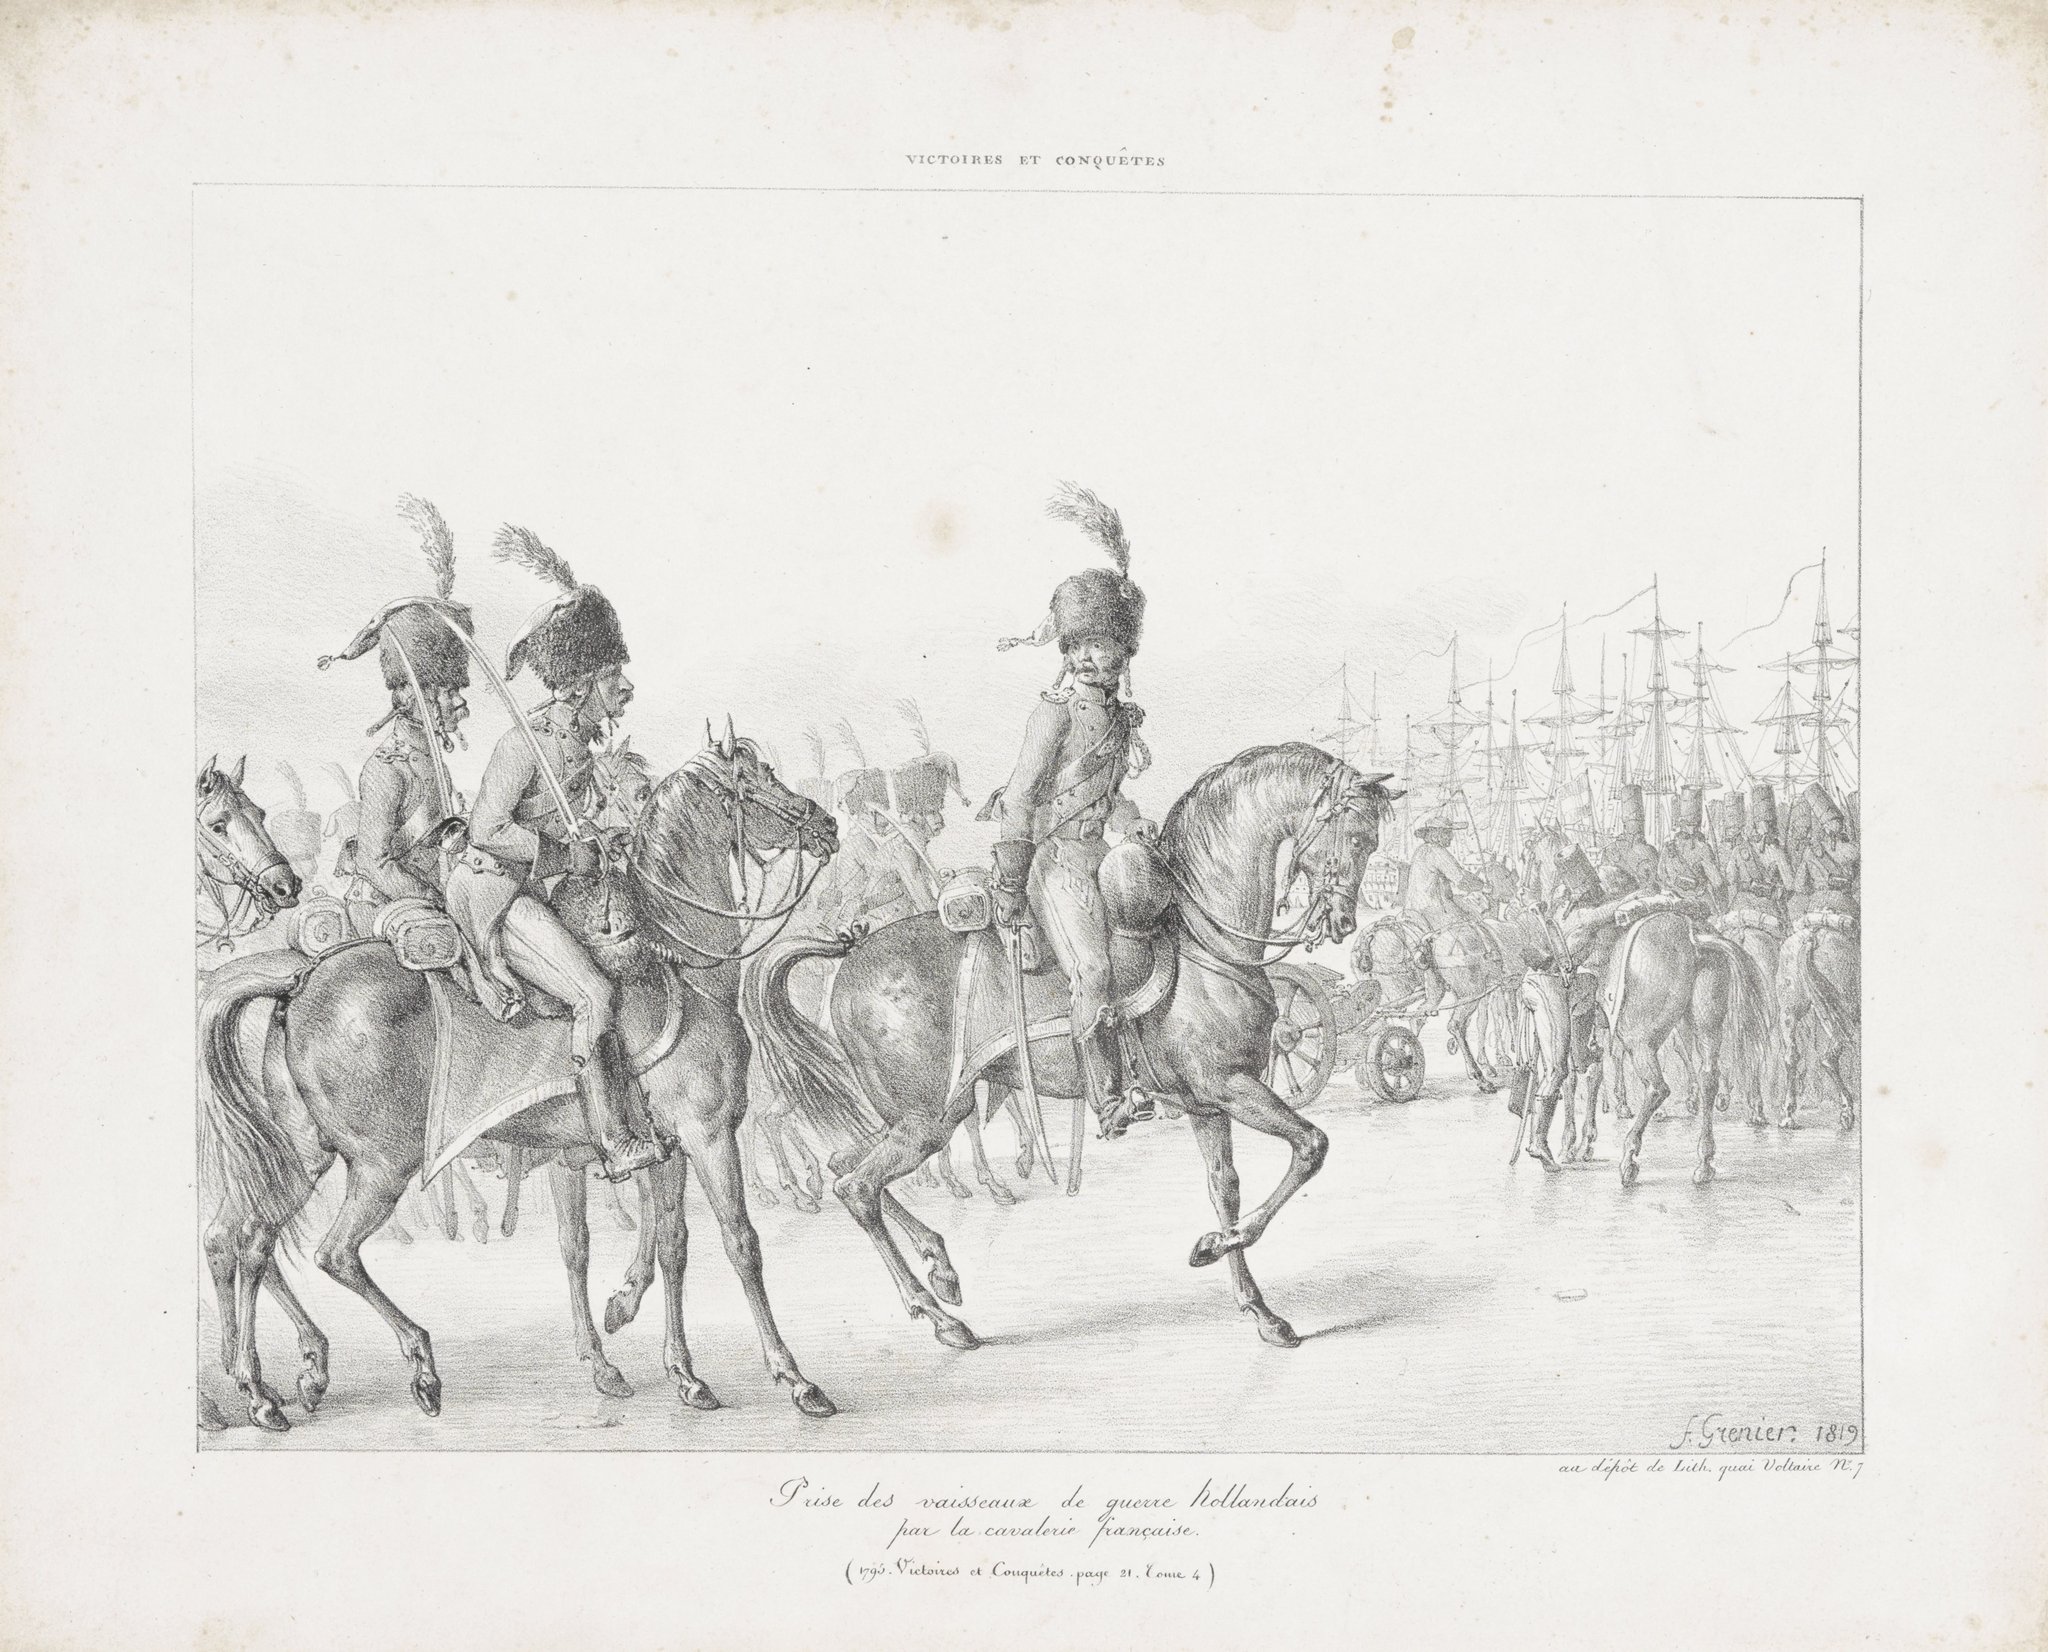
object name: print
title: Victoires et Conquêtes / Prise des Vaisseaux de guerre hollandais par la cavalerie française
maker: françois grenier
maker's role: print maker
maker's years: 1793-1867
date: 1819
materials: paper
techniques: lithograph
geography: france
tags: politician, jean-charles pichegru, battle (+ land forces), den helder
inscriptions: collector's mark: Lugt 2228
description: Franse huzaren onder generaal Pichegru veroveren de schepen van de Staatse vloot, die vastgevroren zitten in het ijs bij Den Helder, 24 januari 1795.